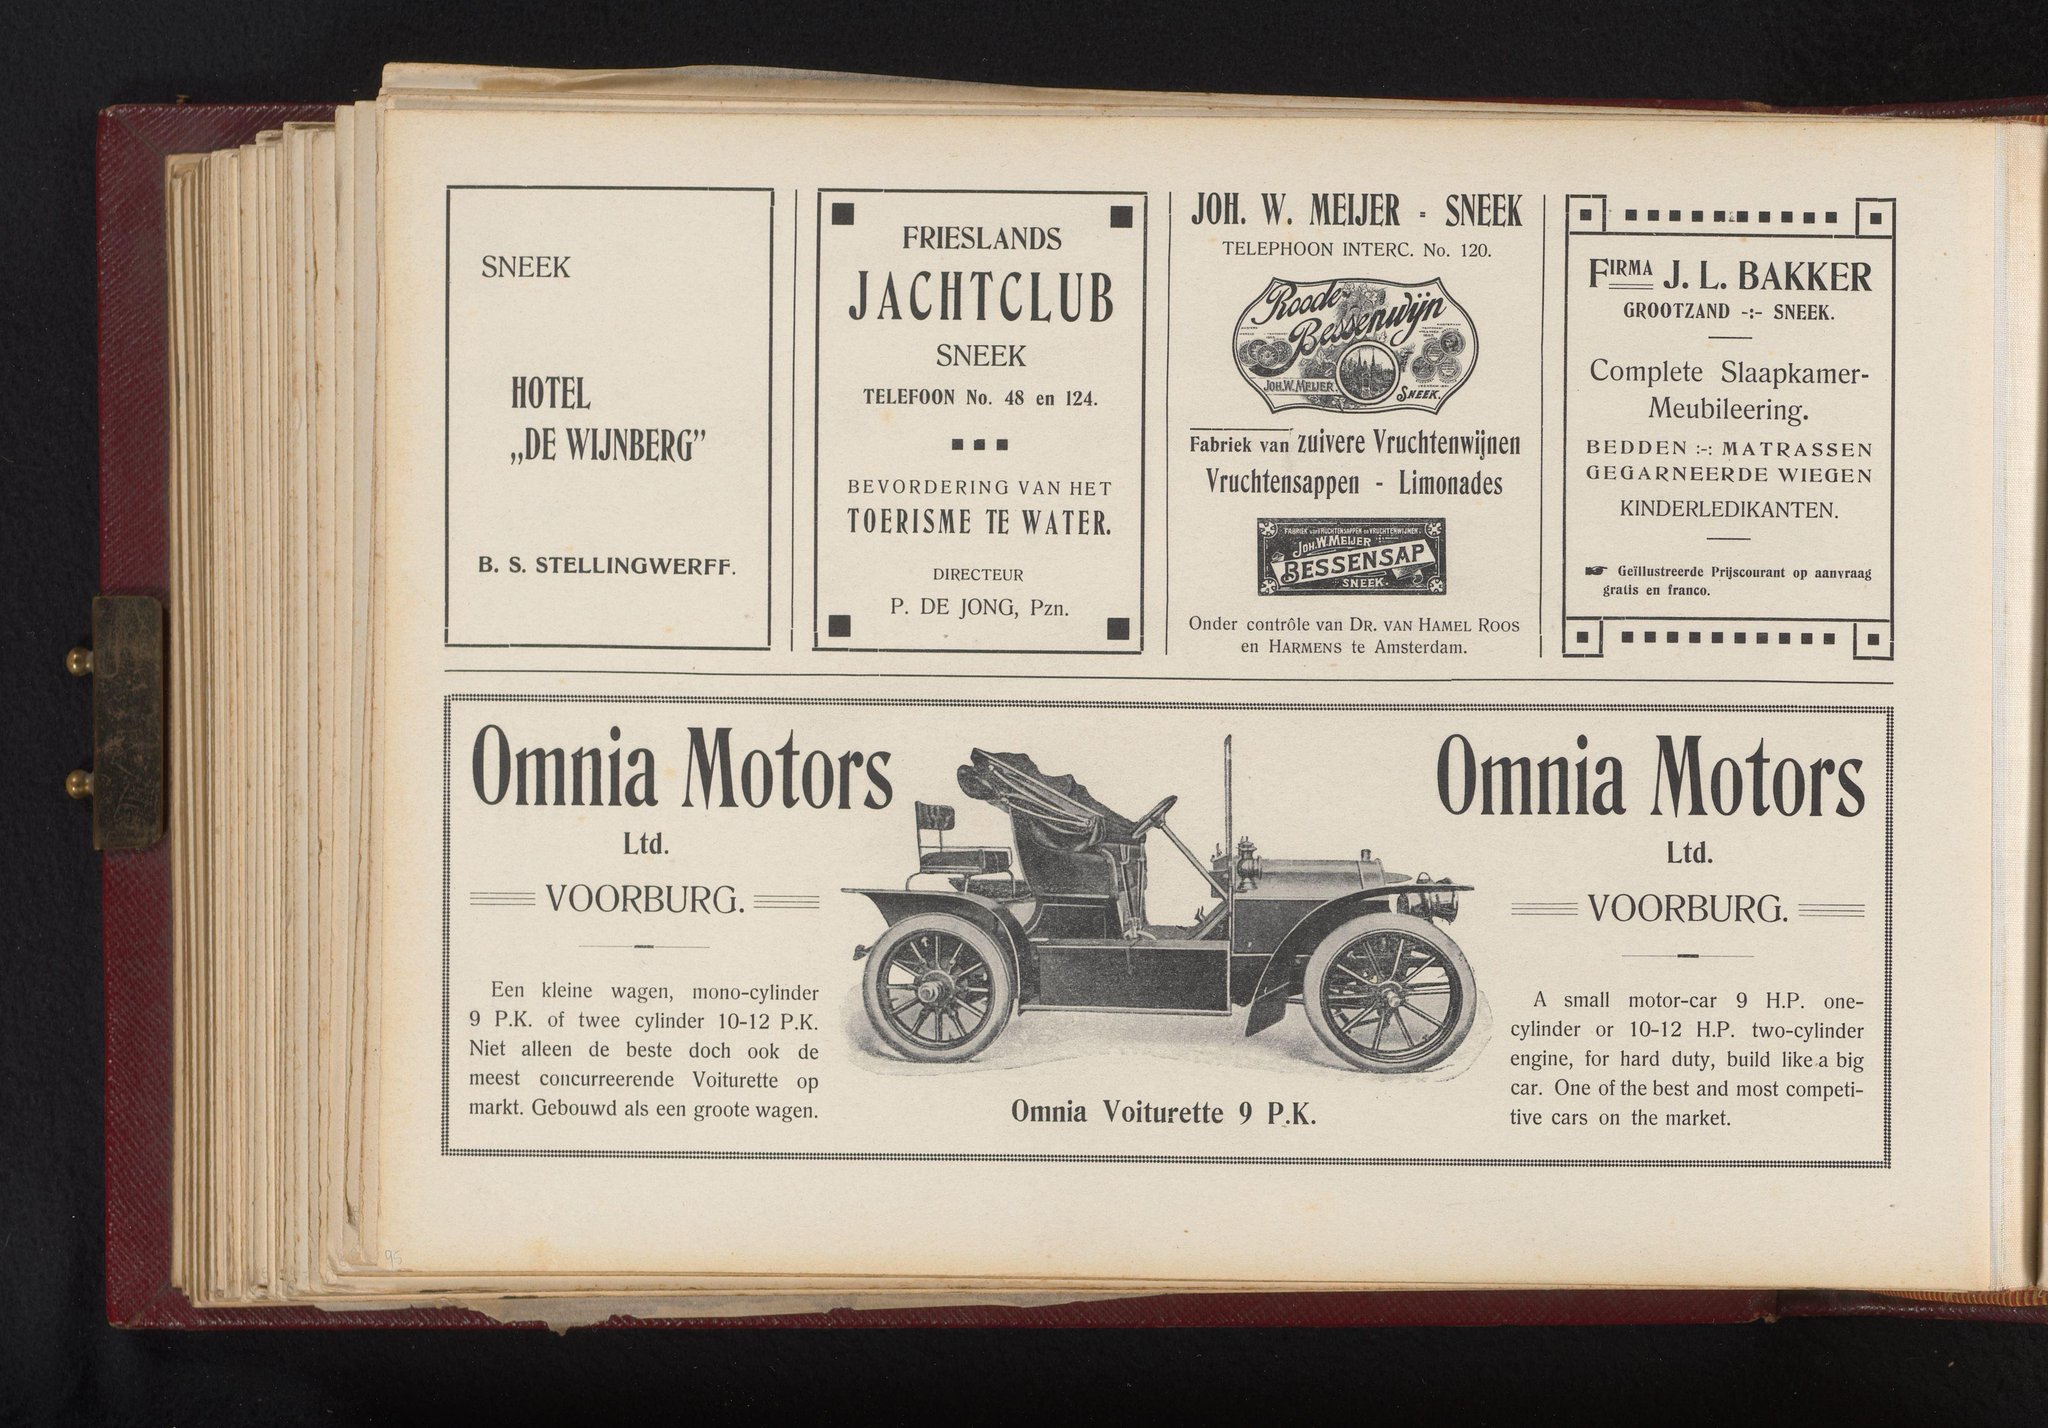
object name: album leaf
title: Advertenties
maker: Anonymous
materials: paper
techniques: printing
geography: netherlands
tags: advertising, automobile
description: Advertenties voor onder andere Hotel de Wijnberg, Jachtclub Sneek, Joh. W. Meijer, Firma J. L. Bakker en Omnia Motors Ltd. De advertentie Omnia Motors Ltd. is voorzien van een afbeelding. Deze pagina maakt deel uit van een album.